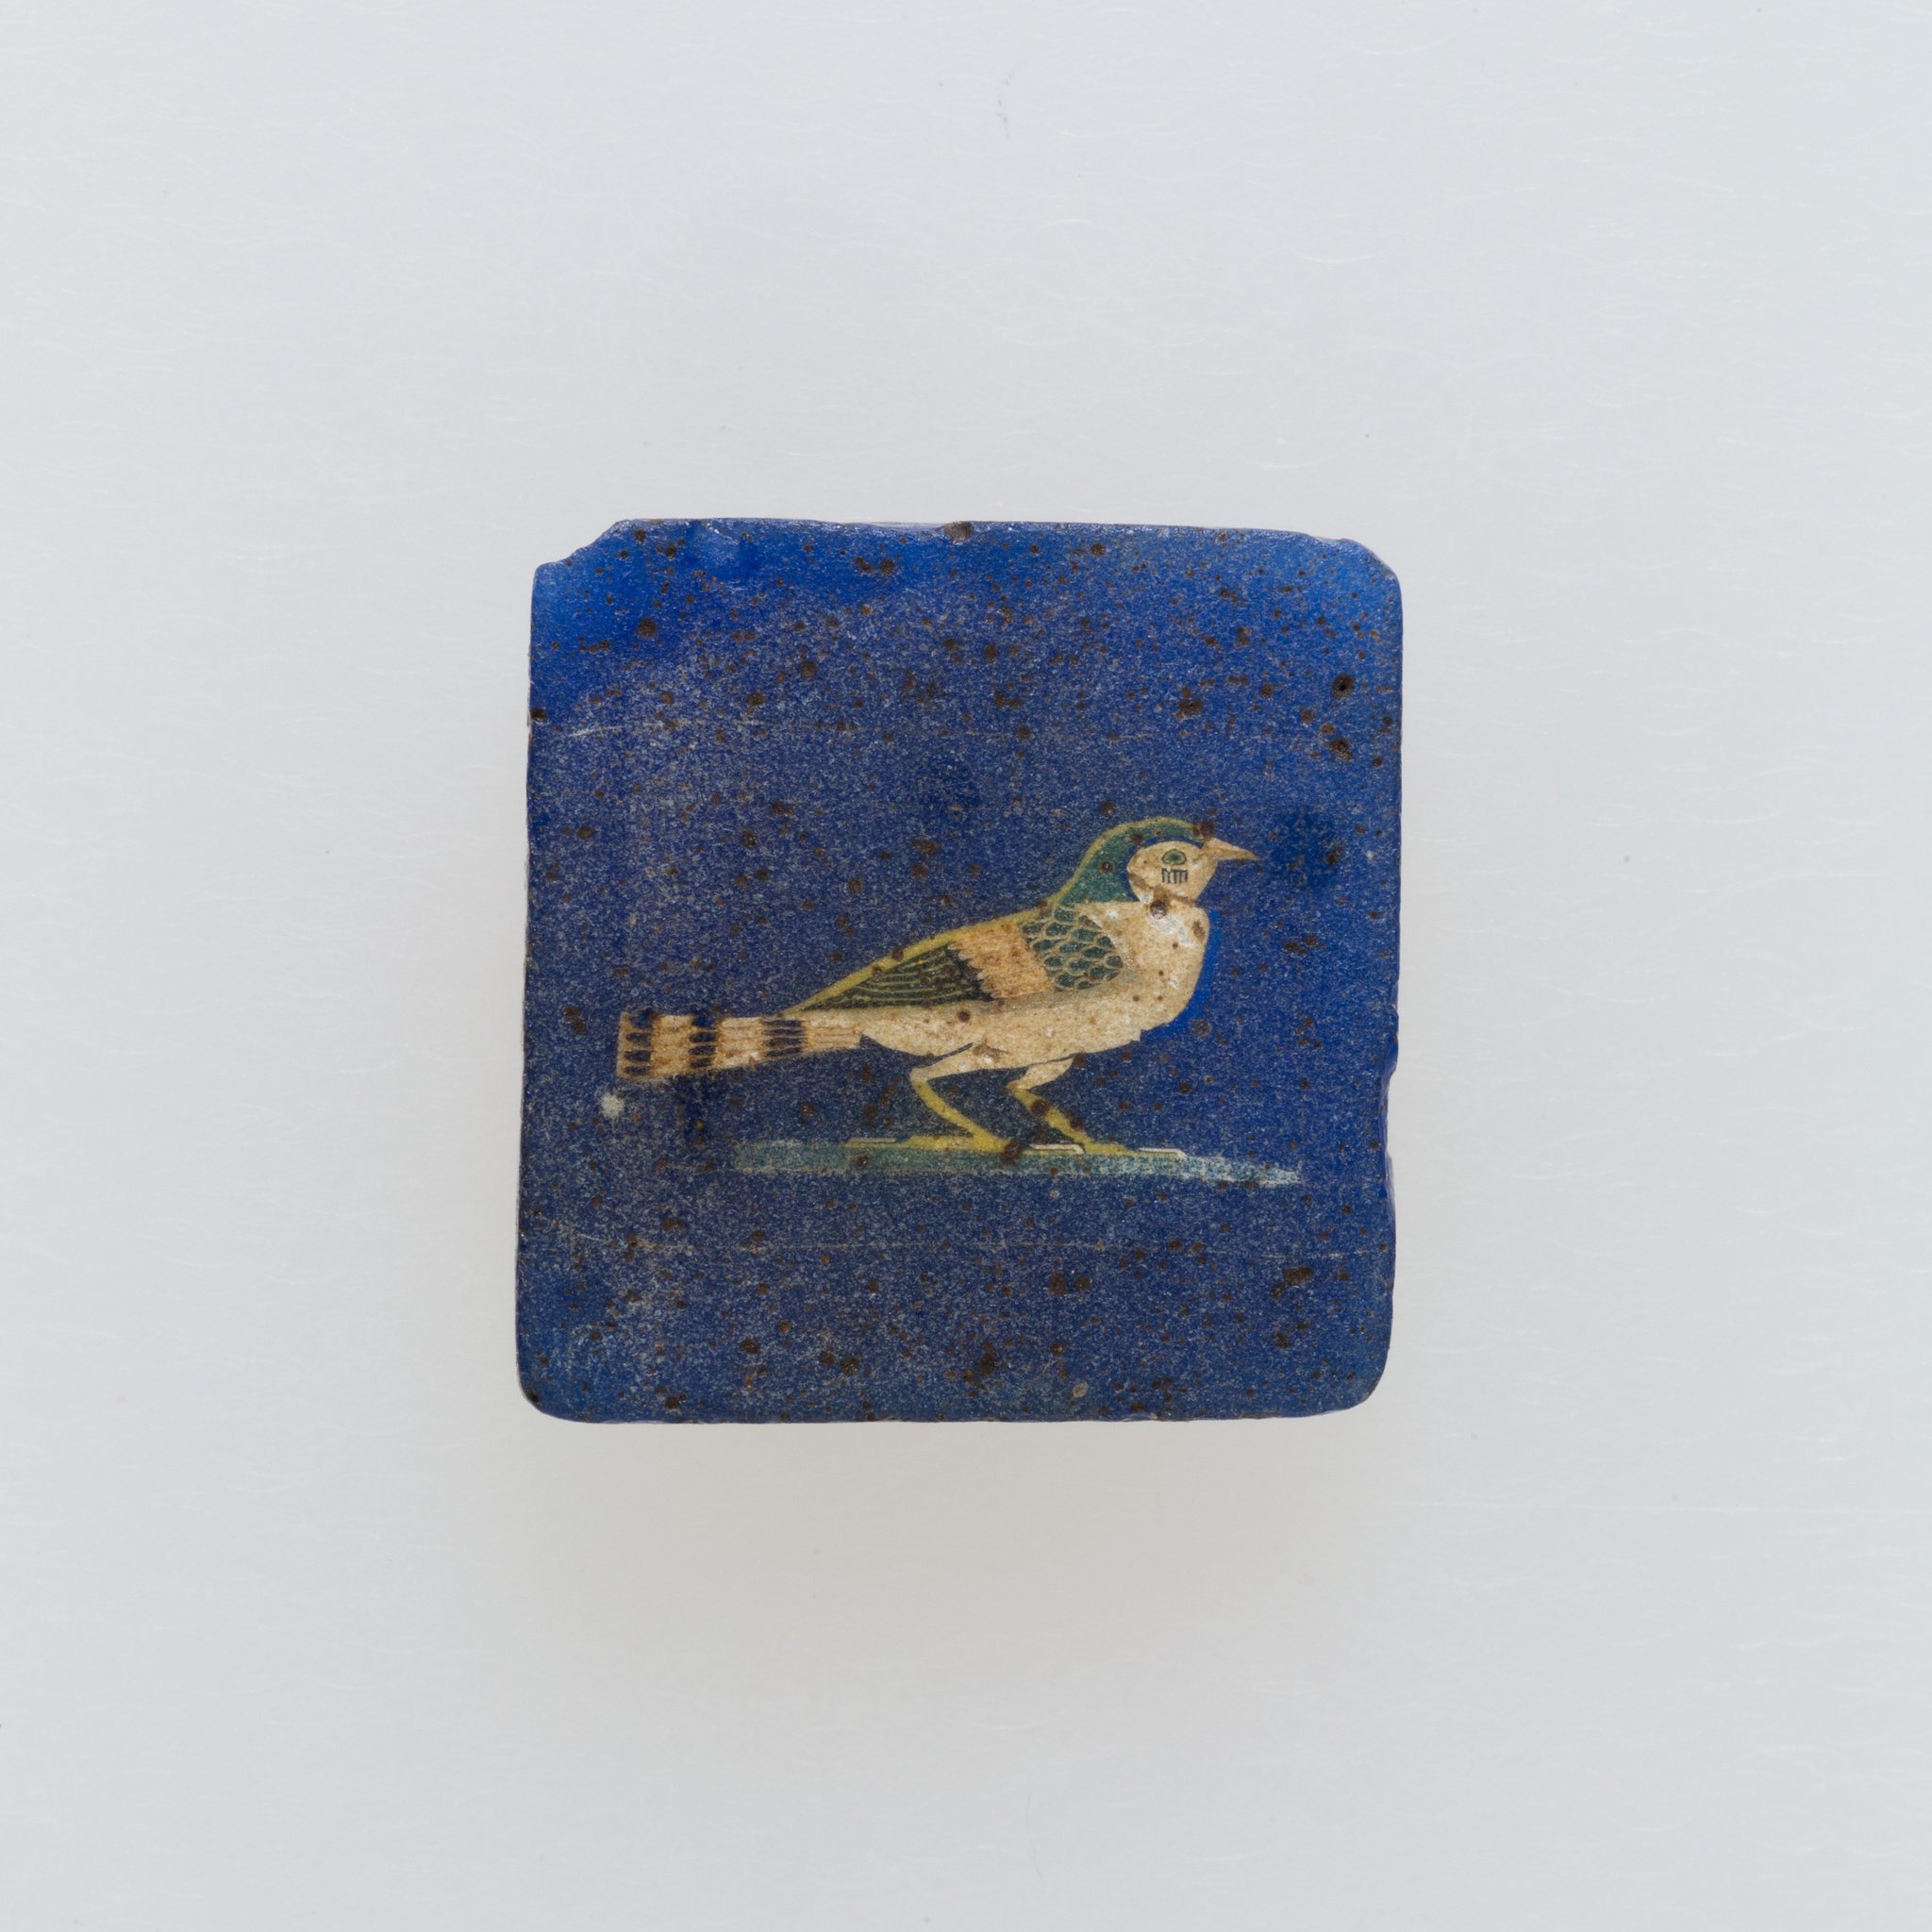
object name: inlay, swallow, hieroglyph, solar symbol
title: A swallow, a solar symbol, in an rectangular inlay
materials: glass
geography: egypt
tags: birds